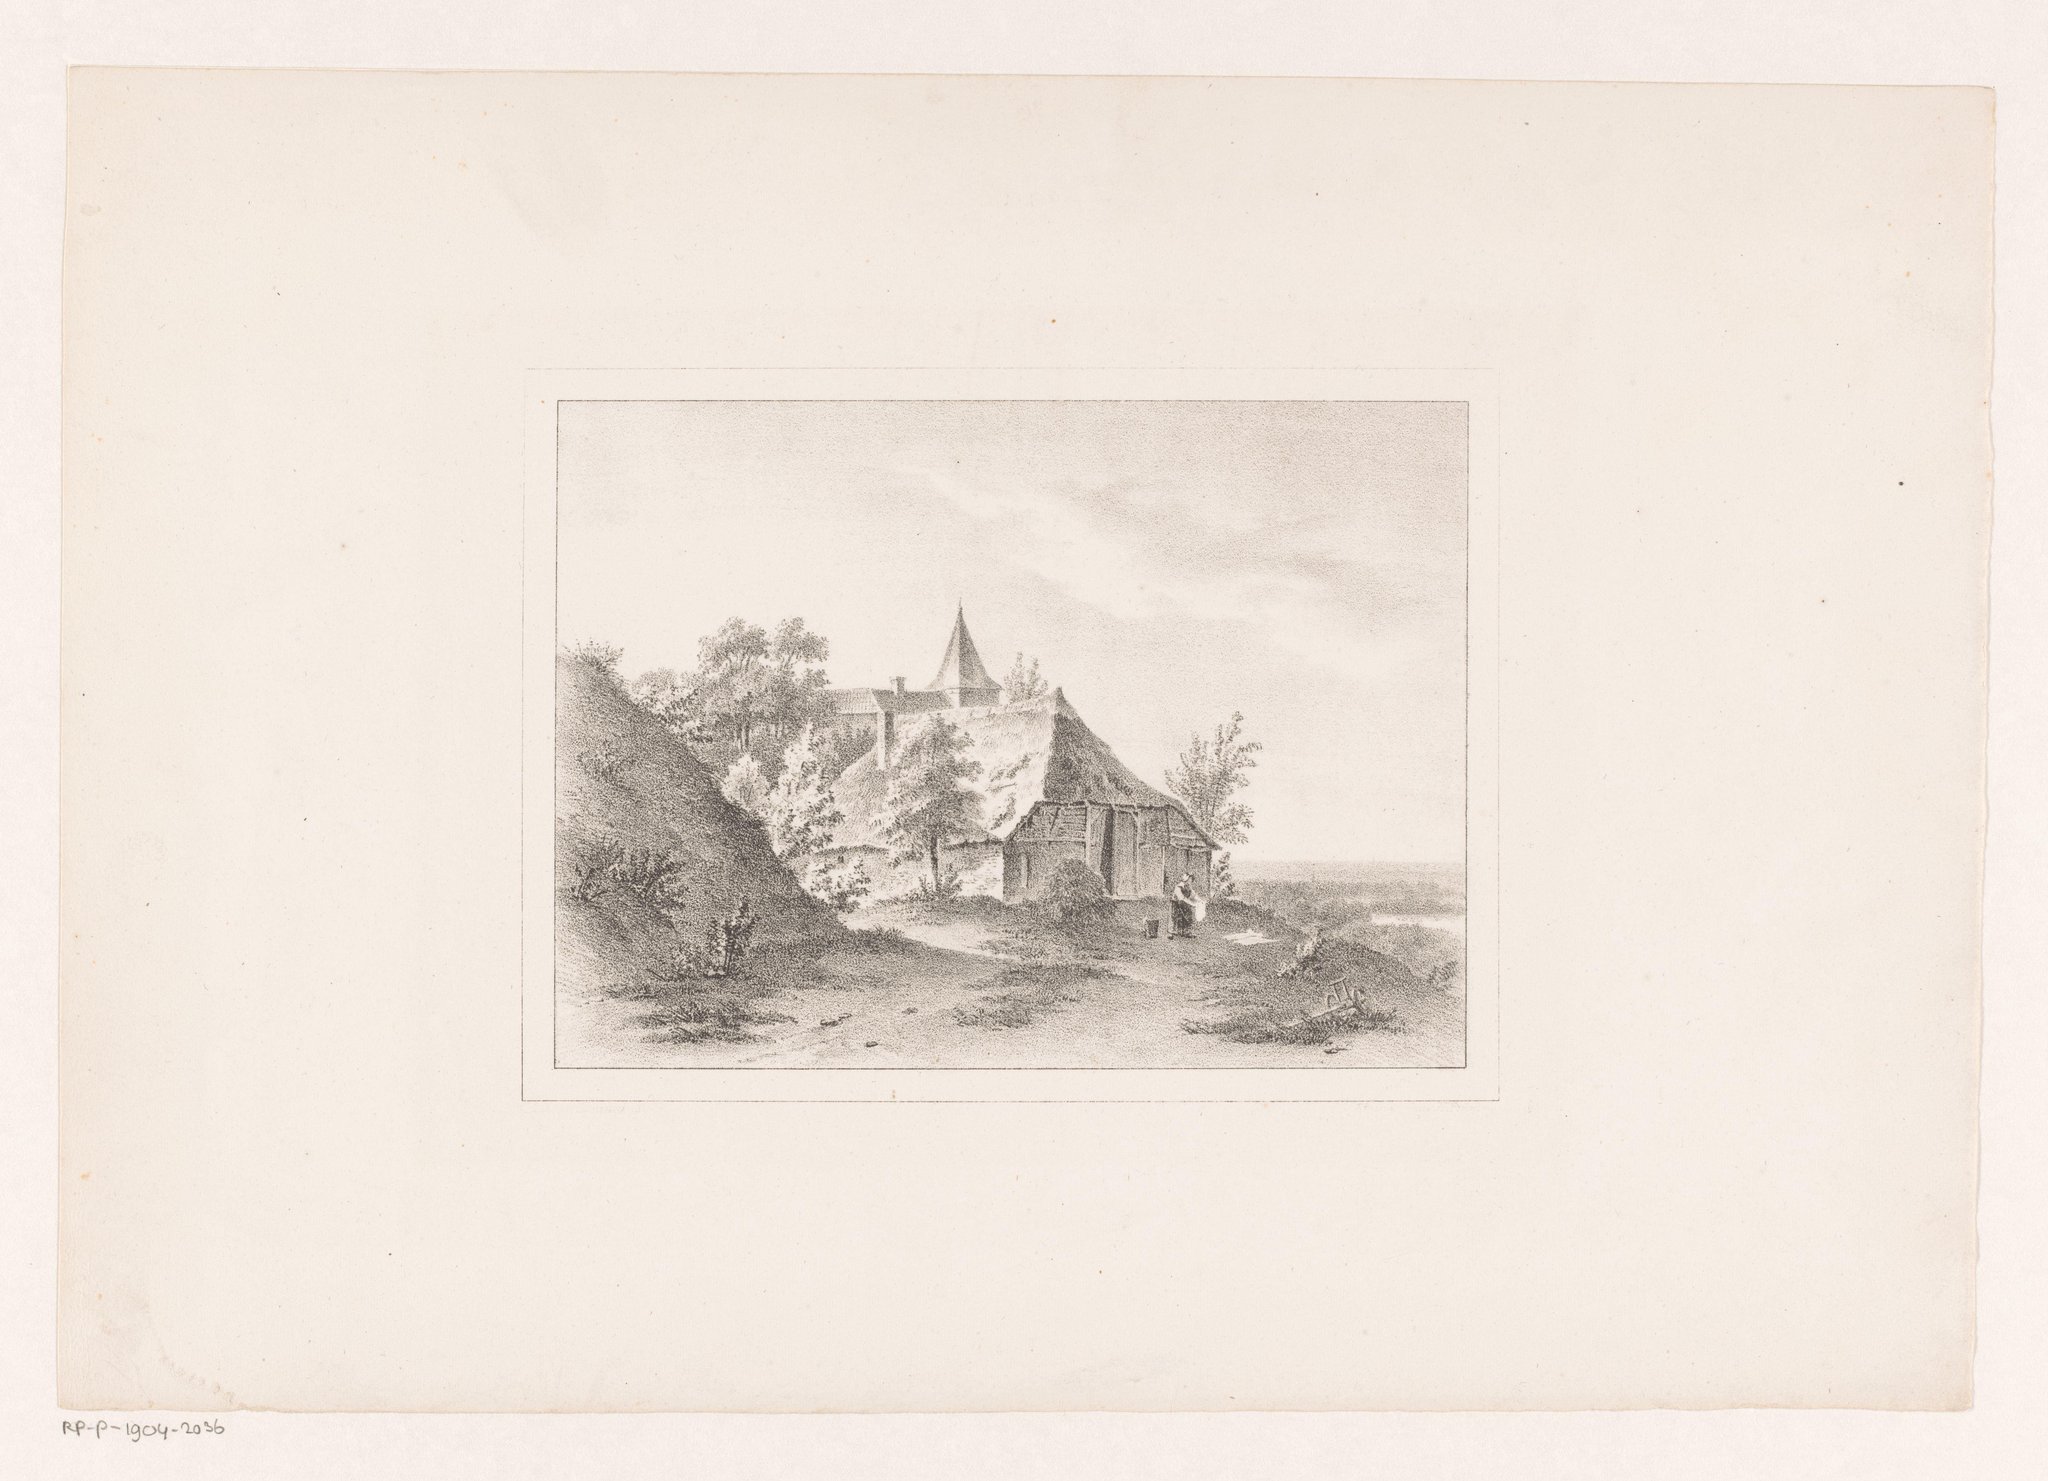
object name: print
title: Dorpsrand met vrouw die de was bleekt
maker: arie ketting de koningh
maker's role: print maker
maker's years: 1815-1867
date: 1825-1867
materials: paper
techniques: lithograph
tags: bleaching (laundering), outskirts of village, building or outbuilding where laundry is done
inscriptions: collector's mark: Lugt 2228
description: Deze prent maakte waarschijnlijk deel uit van een serie waaronder in ieder geval: RP-P-1904-2035, RP-P-1904-2036, RP-P-1904-2037, RP-P-1904-2038.